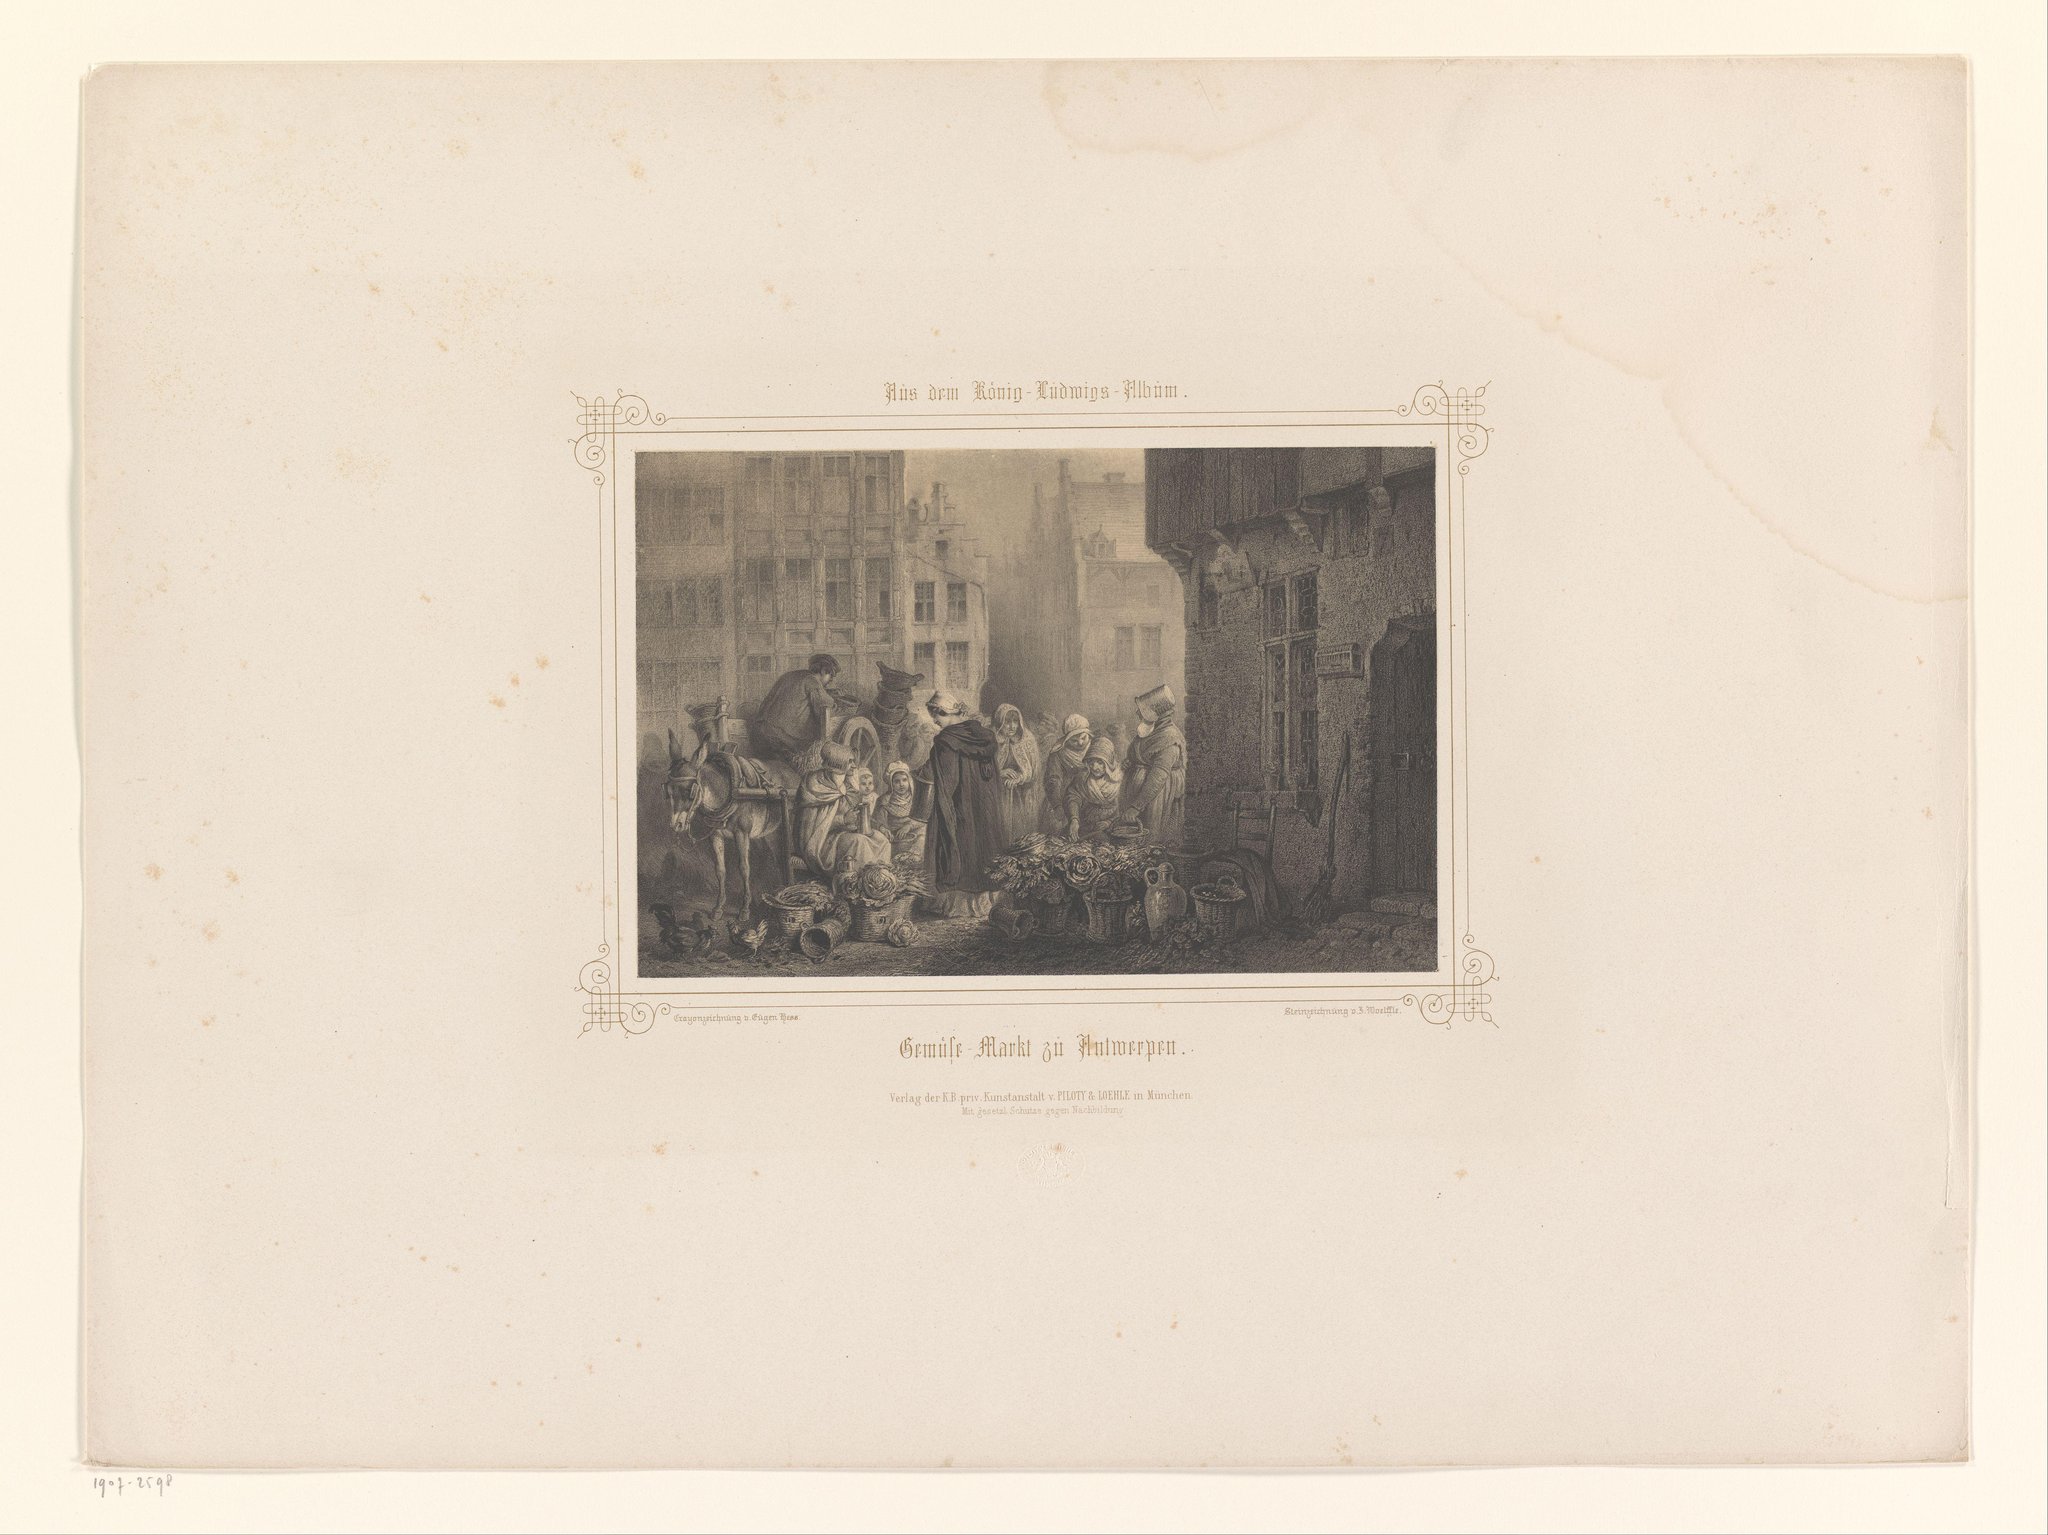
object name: print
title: Album aangeboden aan Lodewijk I van Beieren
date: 1850-1859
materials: paper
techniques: lithograph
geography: munich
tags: vegetables, market, square, place, circus, etc. (+ city(-scape) with figures, staffage), antwerp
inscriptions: check stamp: ‘Piloty&Loehle, München’, collector's mark: Lugt 2228, : ‘Mit gesetzl Schutze gegen Nachbildung’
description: Prent afkomstig uit de serie 'Album Seiner Majestät des Königs Ludwig I. von Bayern', verschenen in verschillende afleveringen. De prenten gaan terug op het album dat Lodewijk I van Beieren op 9 oktober 1850 kreeg overhandigd van verschillende kunstenaars.